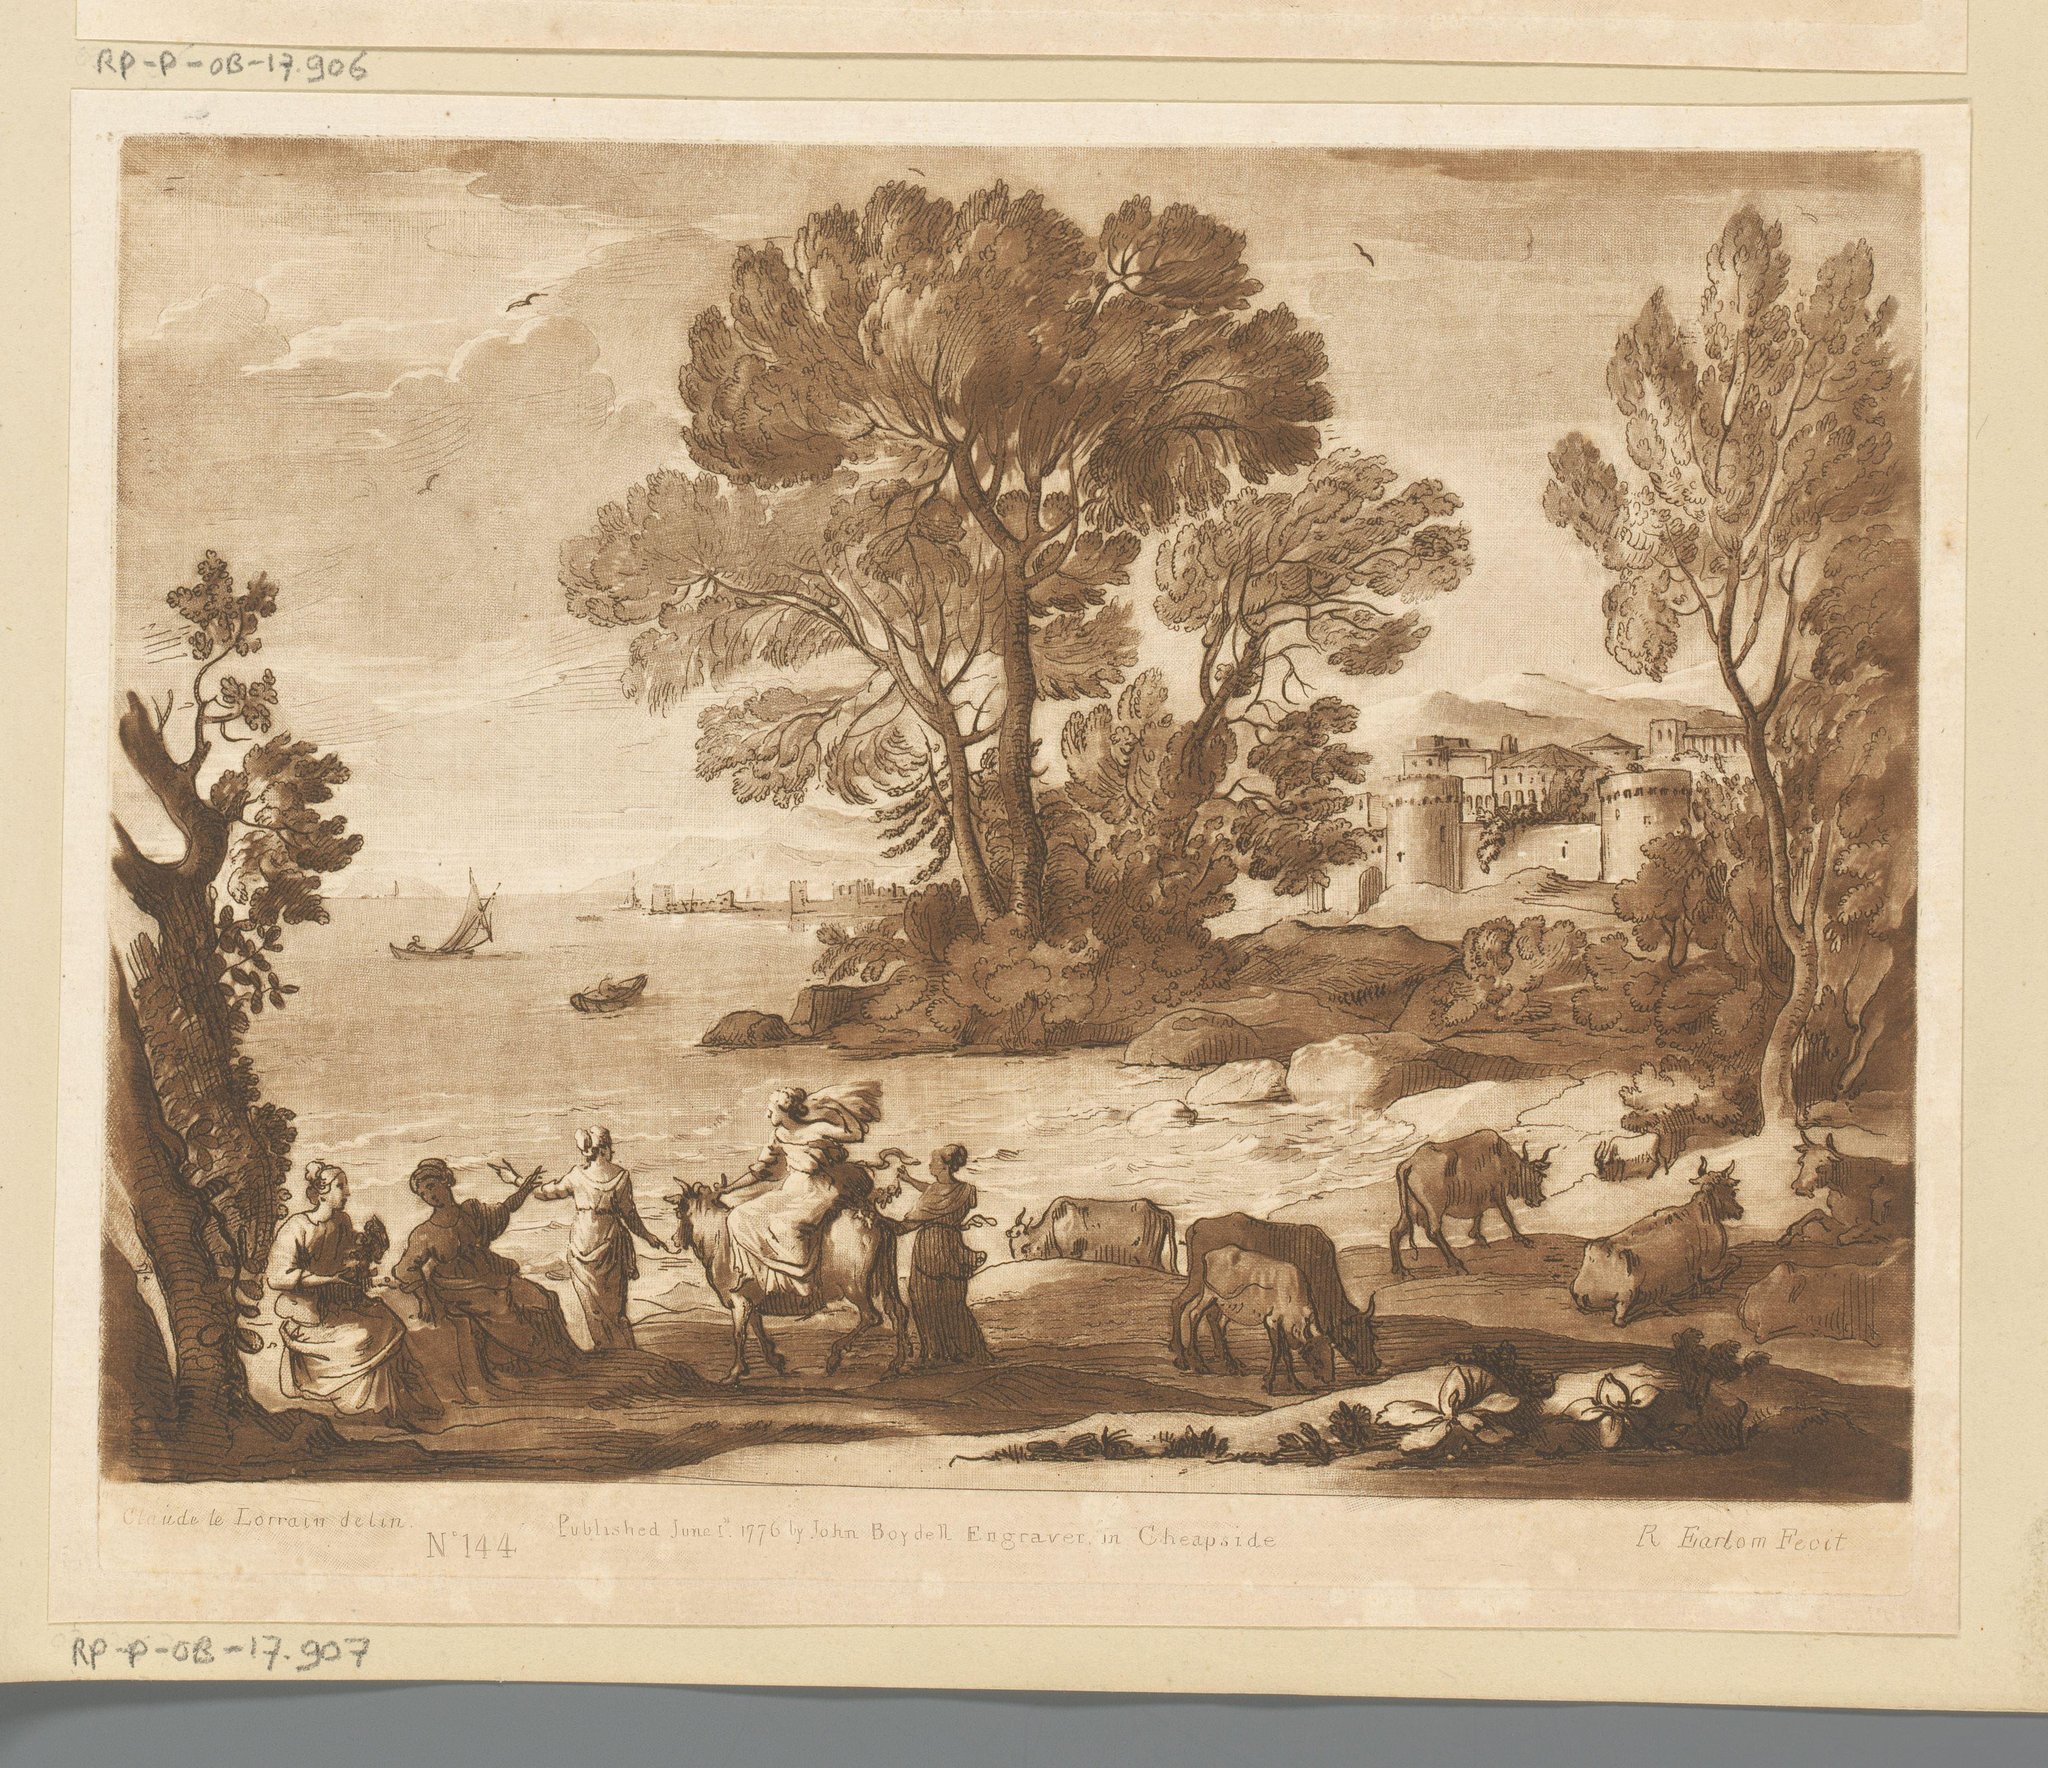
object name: print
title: Liber Veritatis. Or a Collection of Two Hundred Prints, after the original designs of Claude le Lorrain (...)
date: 1776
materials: paper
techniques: etching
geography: london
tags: city-view, and landscape with man-made constructions - ii - ideal landscapes, coast - hh - ideal landscapes, sea (seascape), europa and her maidens play with the bull, and/or adorn it with flowers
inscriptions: date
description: Vanaf 1774 publiceerde John Boydell tweehonderd prenten naar het tekeningenboek Liber Veritatis van Claude Lorrain, in het bezit van de hertogen van Cavendish. Deze prenten werden vanaf 1777 in twee volumes gebundeld uitgegeven.